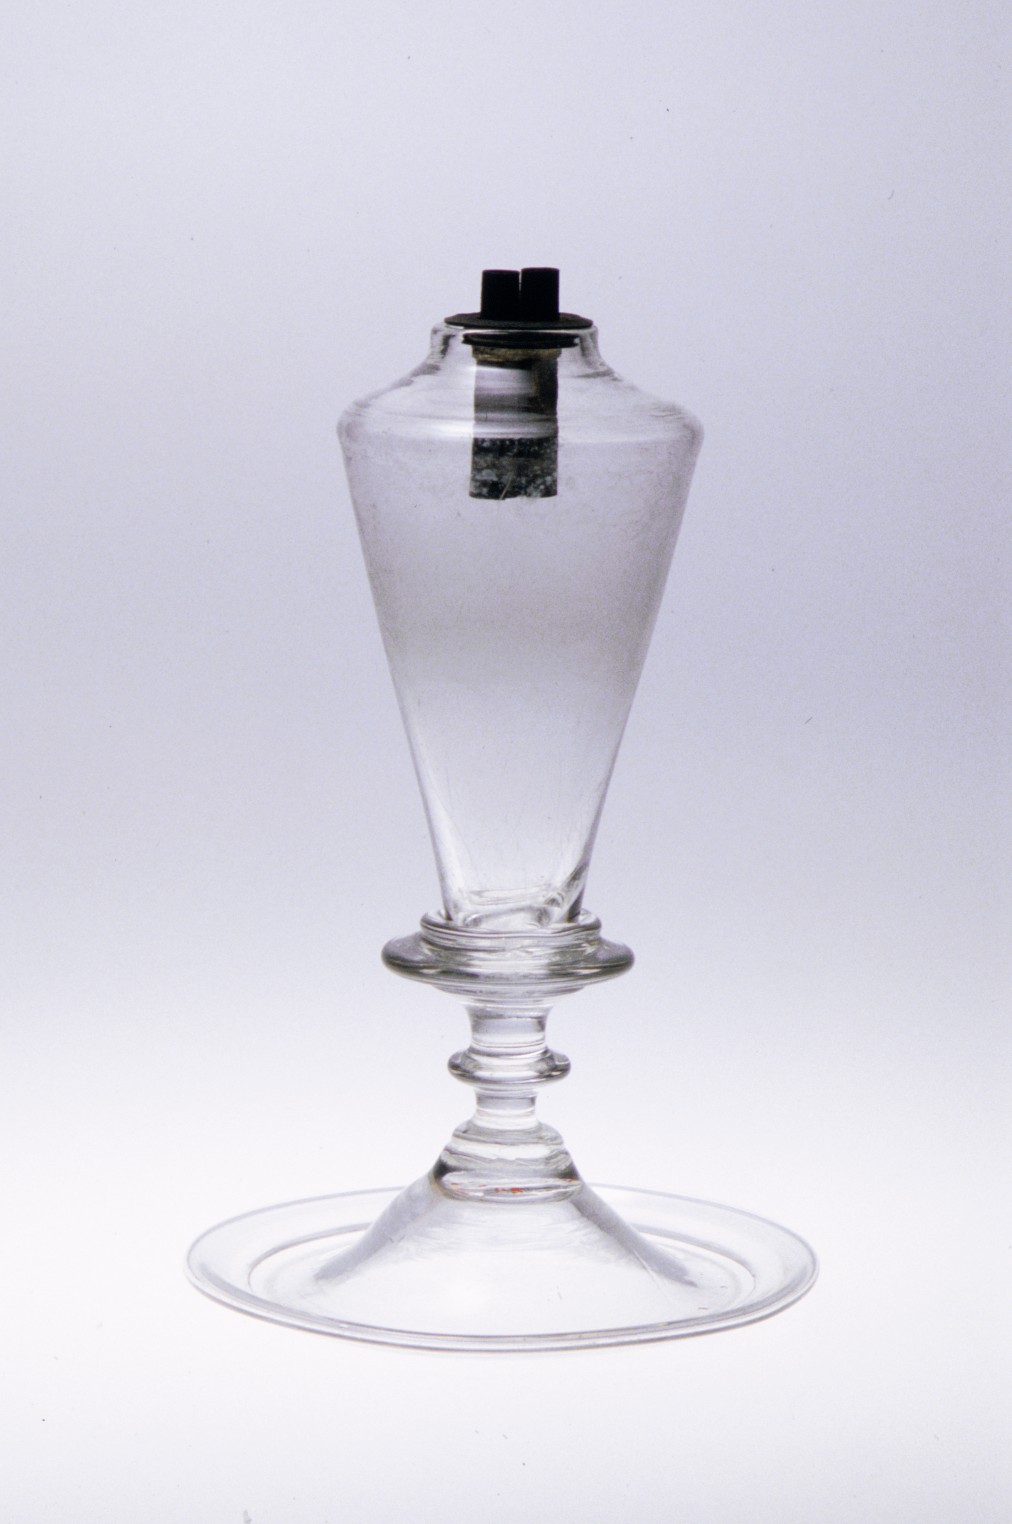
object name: whale oil lamp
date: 1830-1850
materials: glass, lead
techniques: glassblowing, pressed